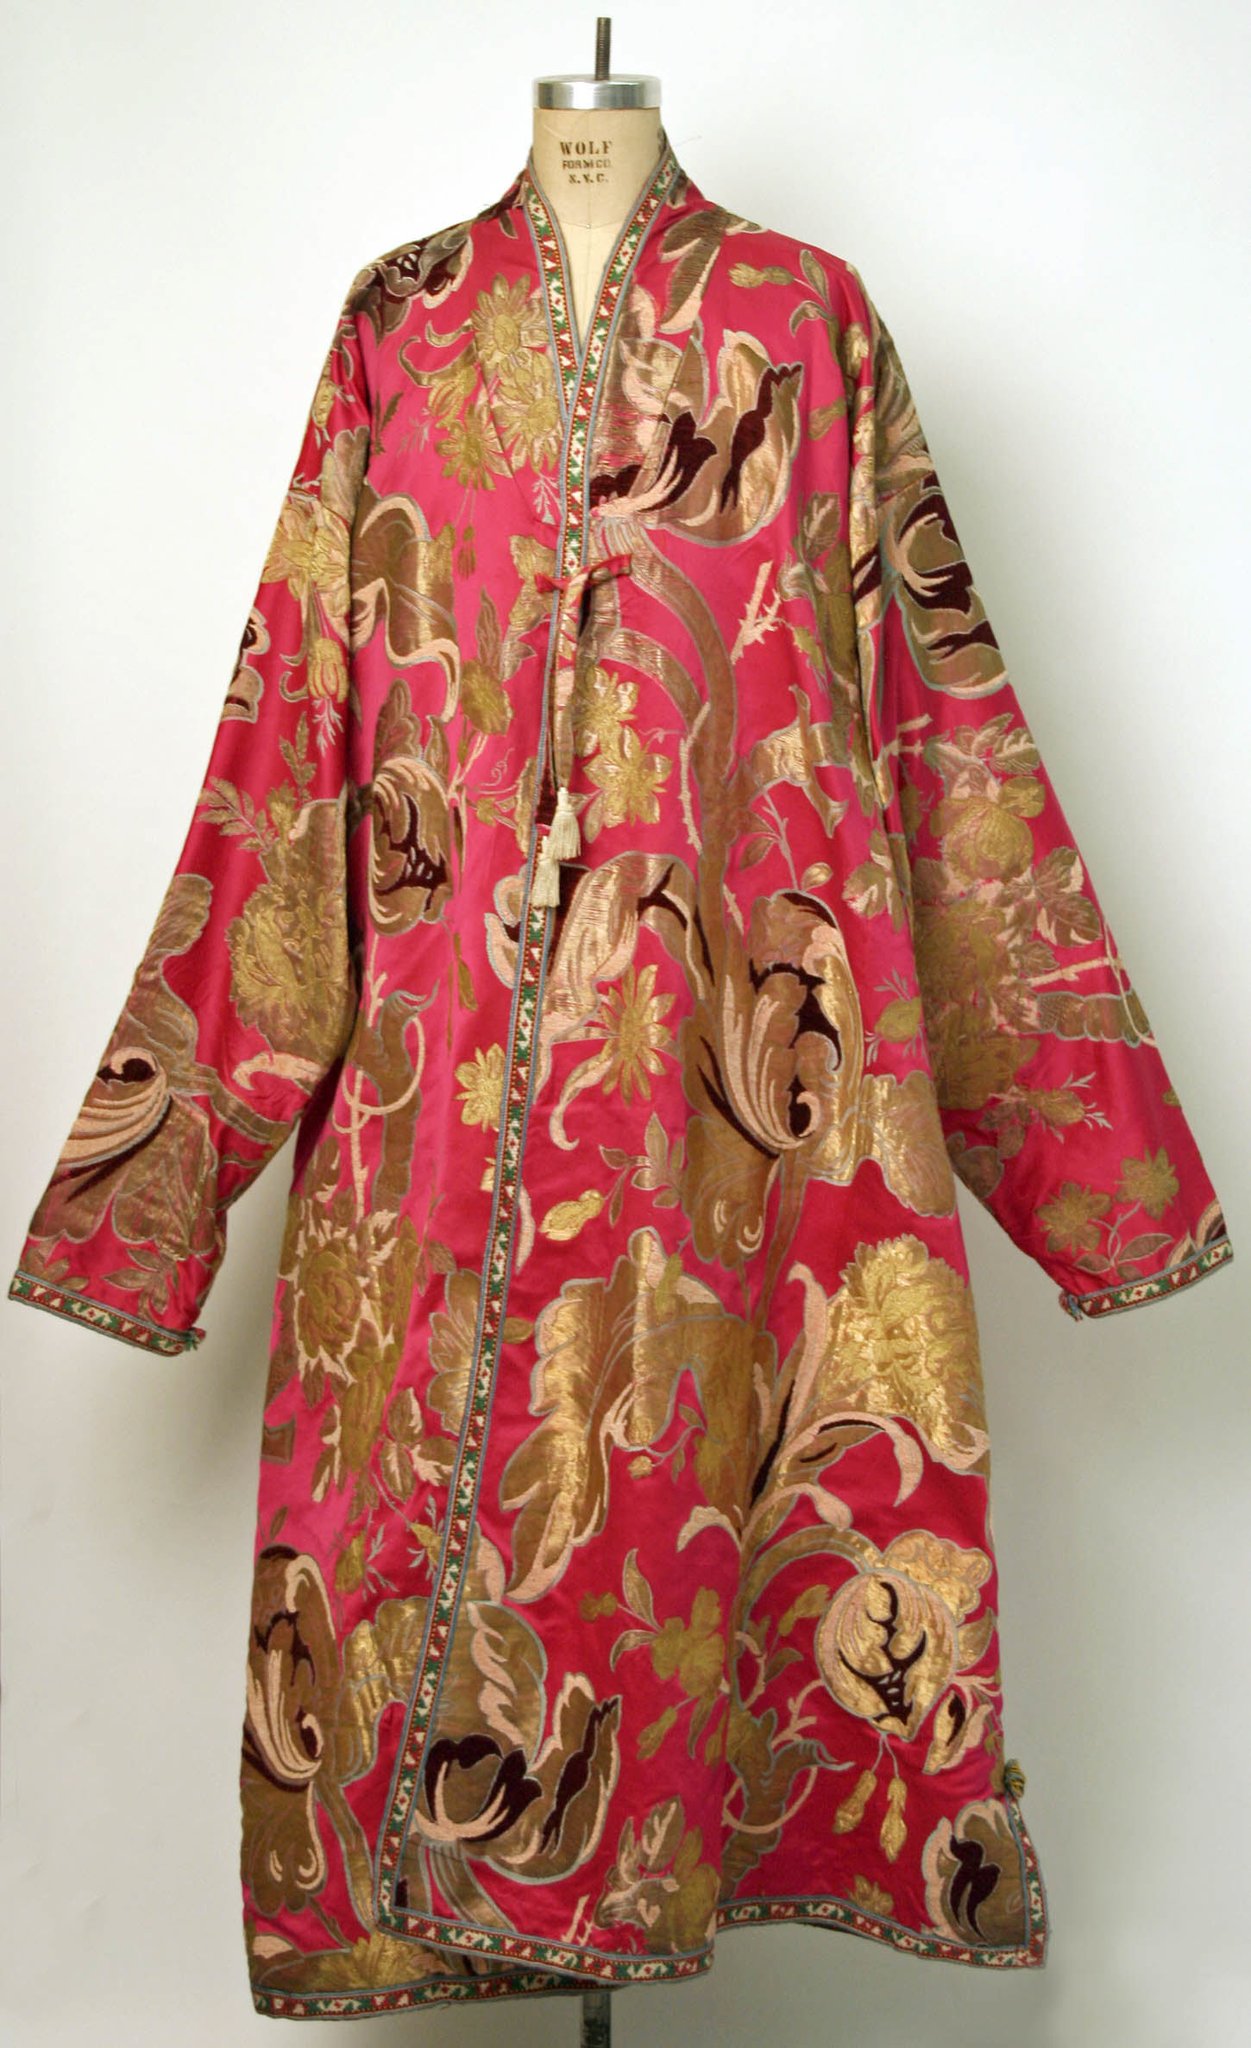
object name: robe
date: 1801-1900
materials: metal thread, silk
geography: uzbekistan